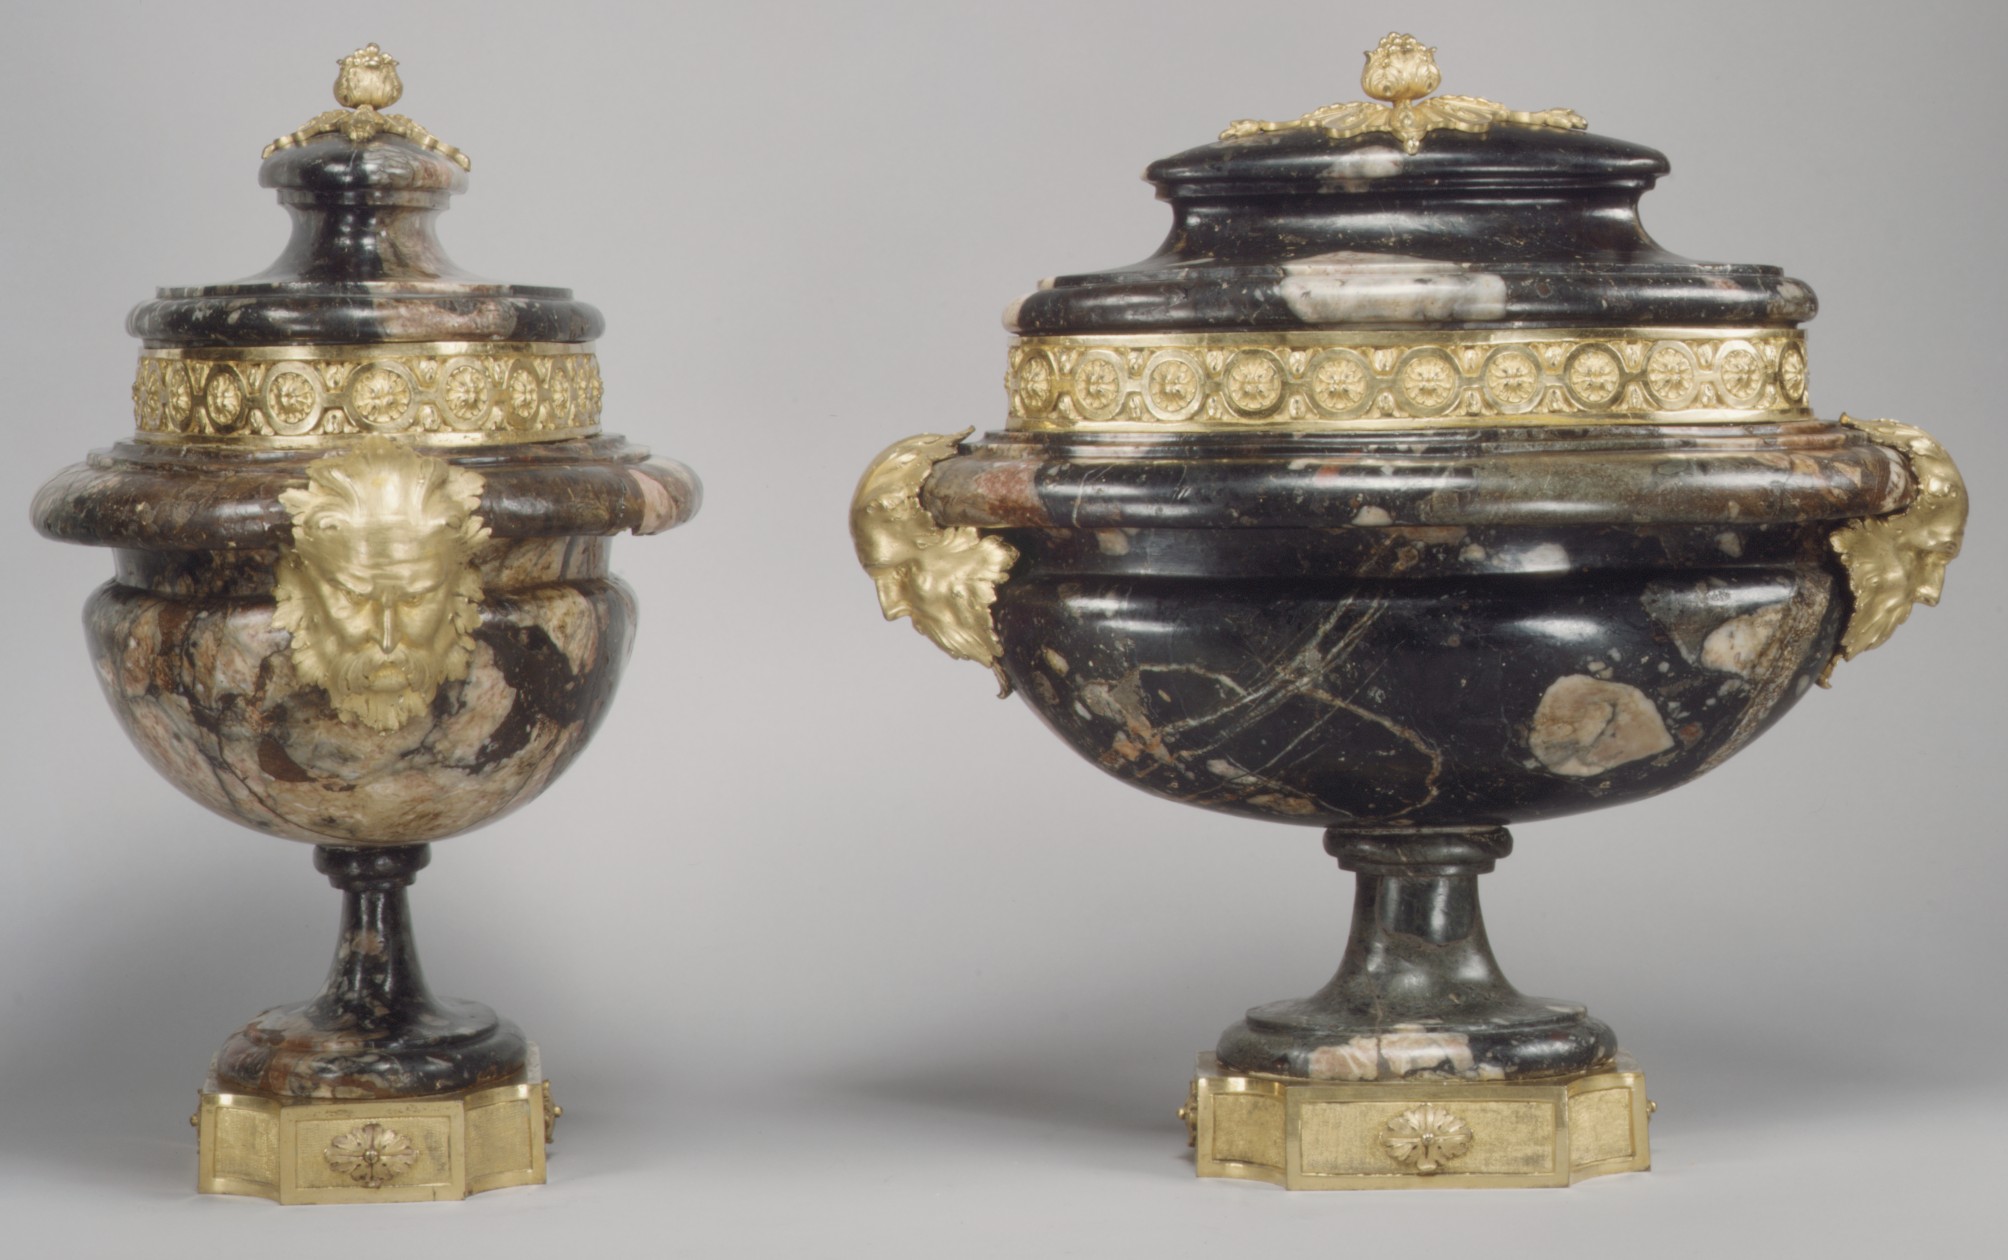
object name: urn with cover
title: Pair of urns with covers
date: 1775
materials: gilt bronze, marble